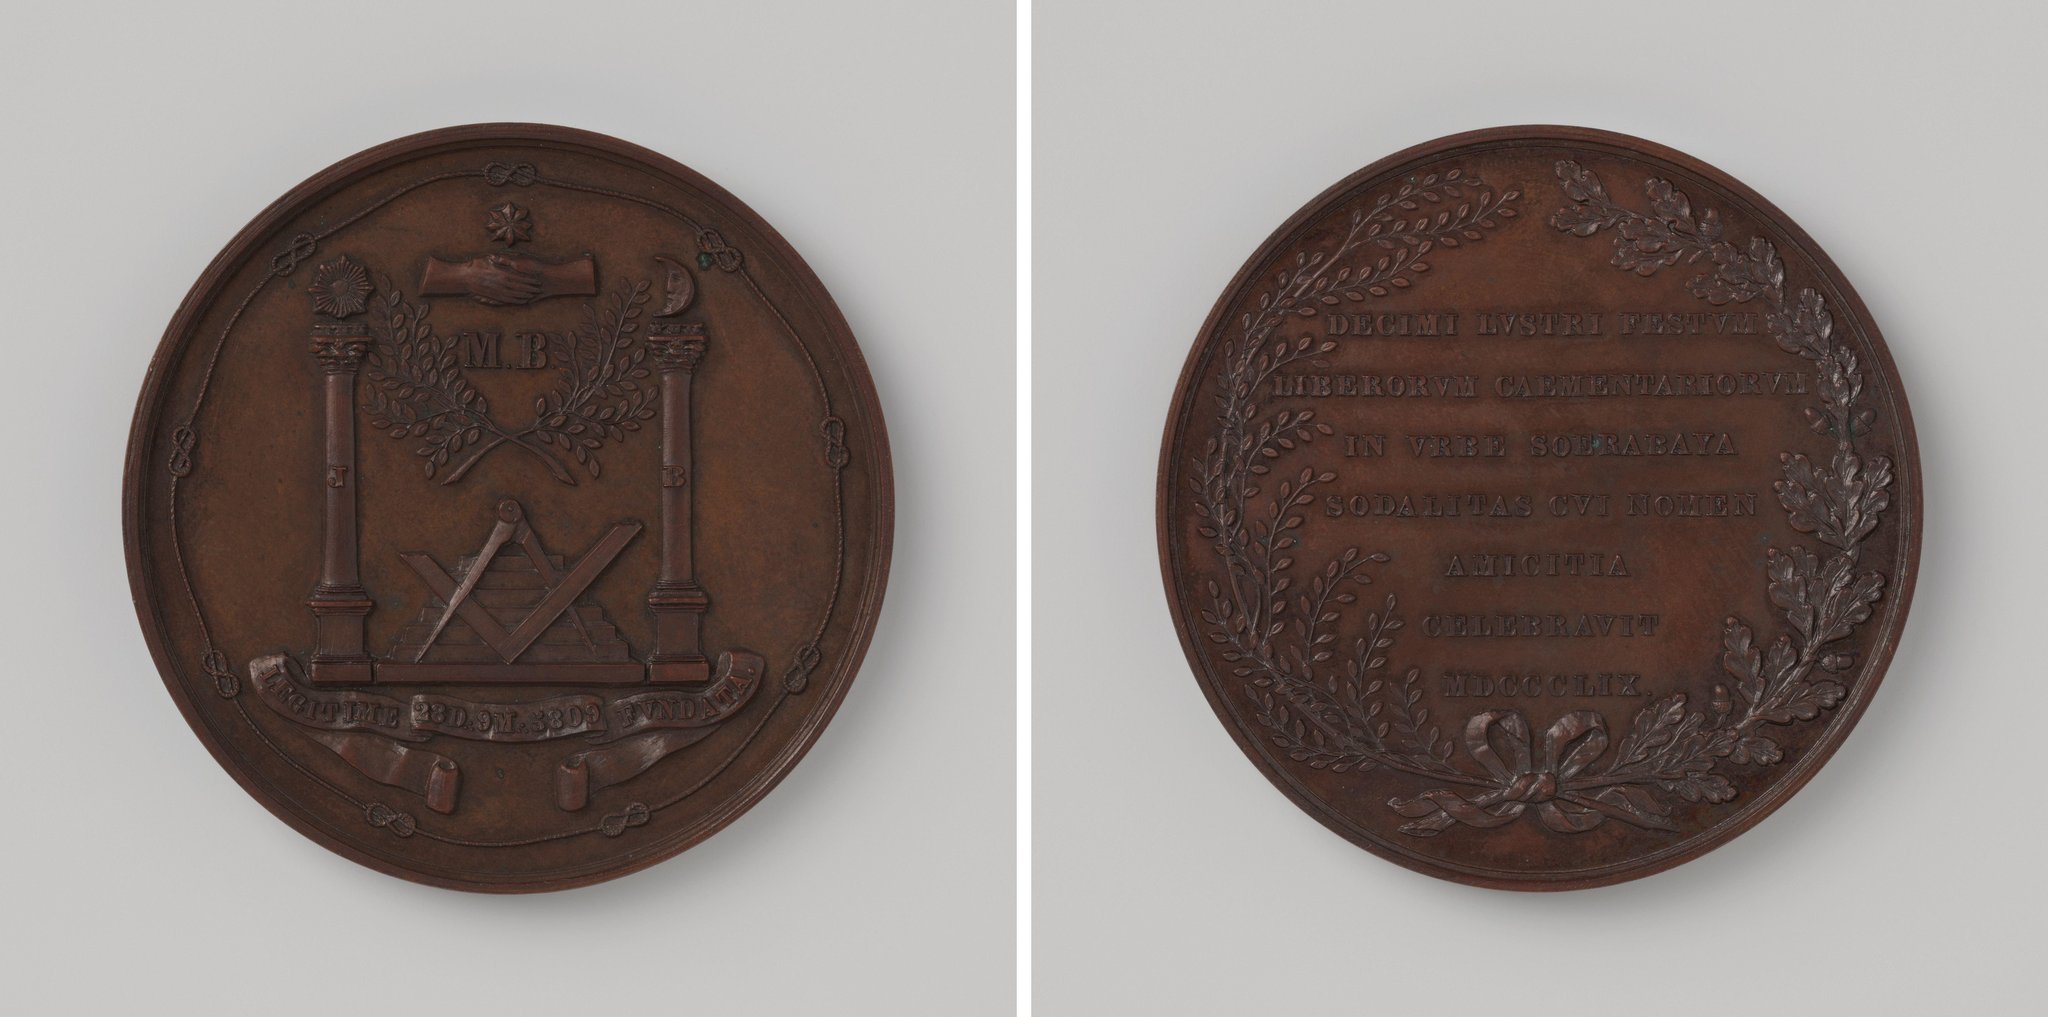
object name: history medal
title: Vijftigjarig bestaan van de loge der vrijmetselaars Amicitia te Soerabaya 1859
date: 1859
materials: bronze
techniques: striking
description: Bronzen penning, op de voorzijde twee zuilen waartussen een ster, ineengeslagen handen, de letters M.B. tussen gekruisde acaciatakken en een trap waarop een passer en driehoek, onderaan een tekstlint, alles binnnen een kord met negen knopen, op de keerzijde zeven regels tekst tussen samengestrikte acacia- en eikentakken.